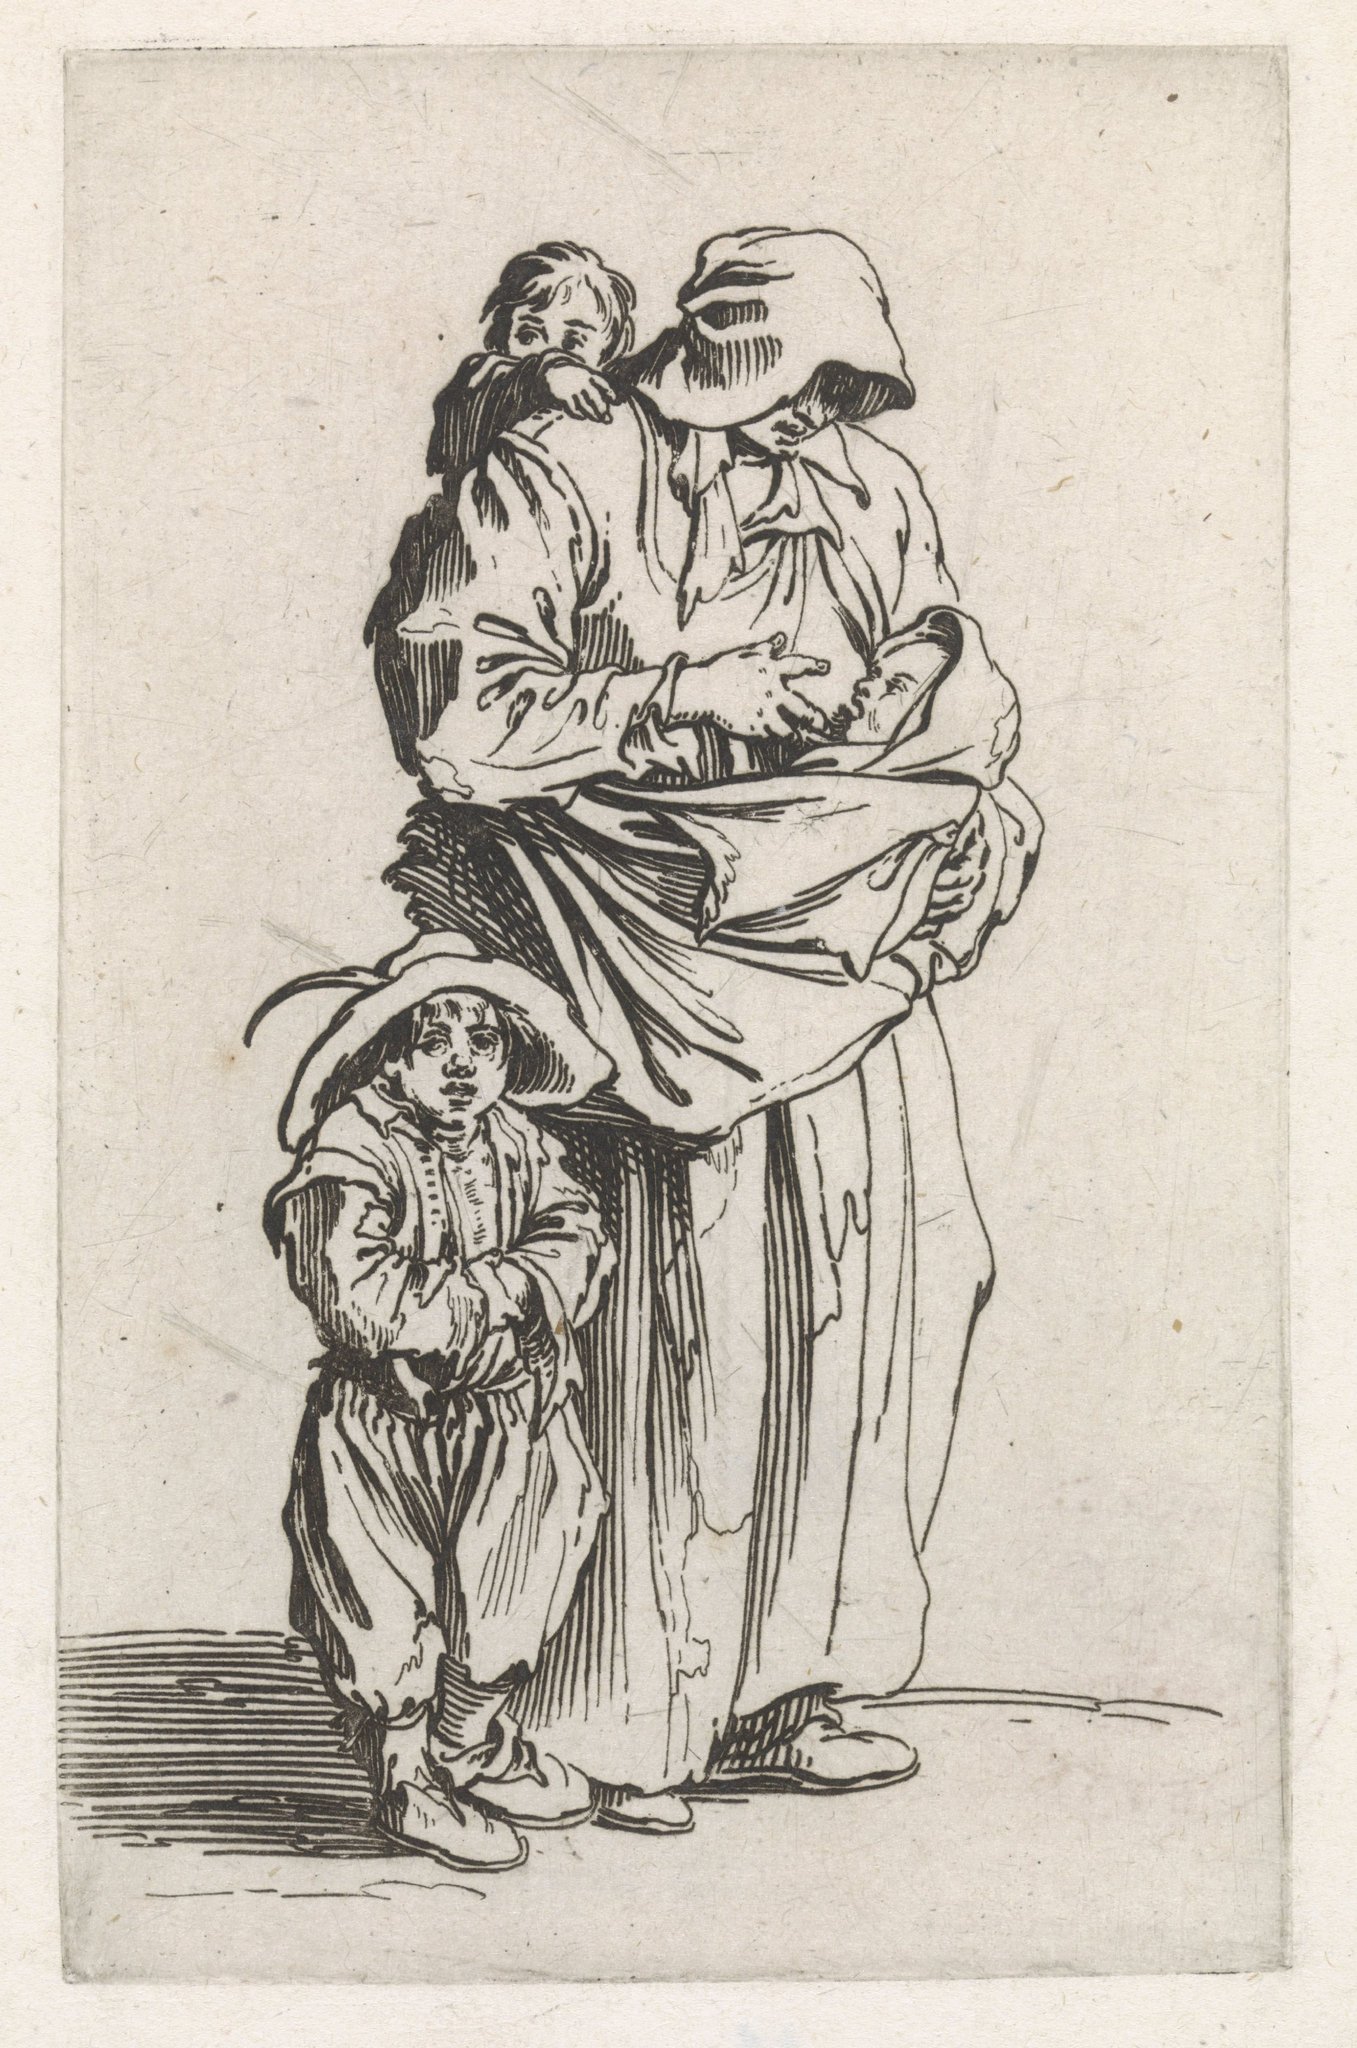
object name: print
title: Les Gueux / Les Mendiants / Les Baroni / Les Barons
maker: jacques callot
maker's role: draughtsman, print maker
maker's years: 1592-1635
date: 1622-1623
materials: paper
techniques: etching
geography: nancy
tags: nursing, suckling, feeding a baby, mother and baby or young child, beggar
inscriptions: collector's mark: Lugt 240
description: Vrouw, gekleed in lompen, van voren gezien, een kleine jongen aan haar rechterzijde, een peuter op haar rug en een baby in haar armen, die zij de borst geeft. Deze prent is onderdeel van een serie van 25 prenten met bedelaars en zwervers, zoals Callot die waarschijnlijk in Italië heeft gezien.